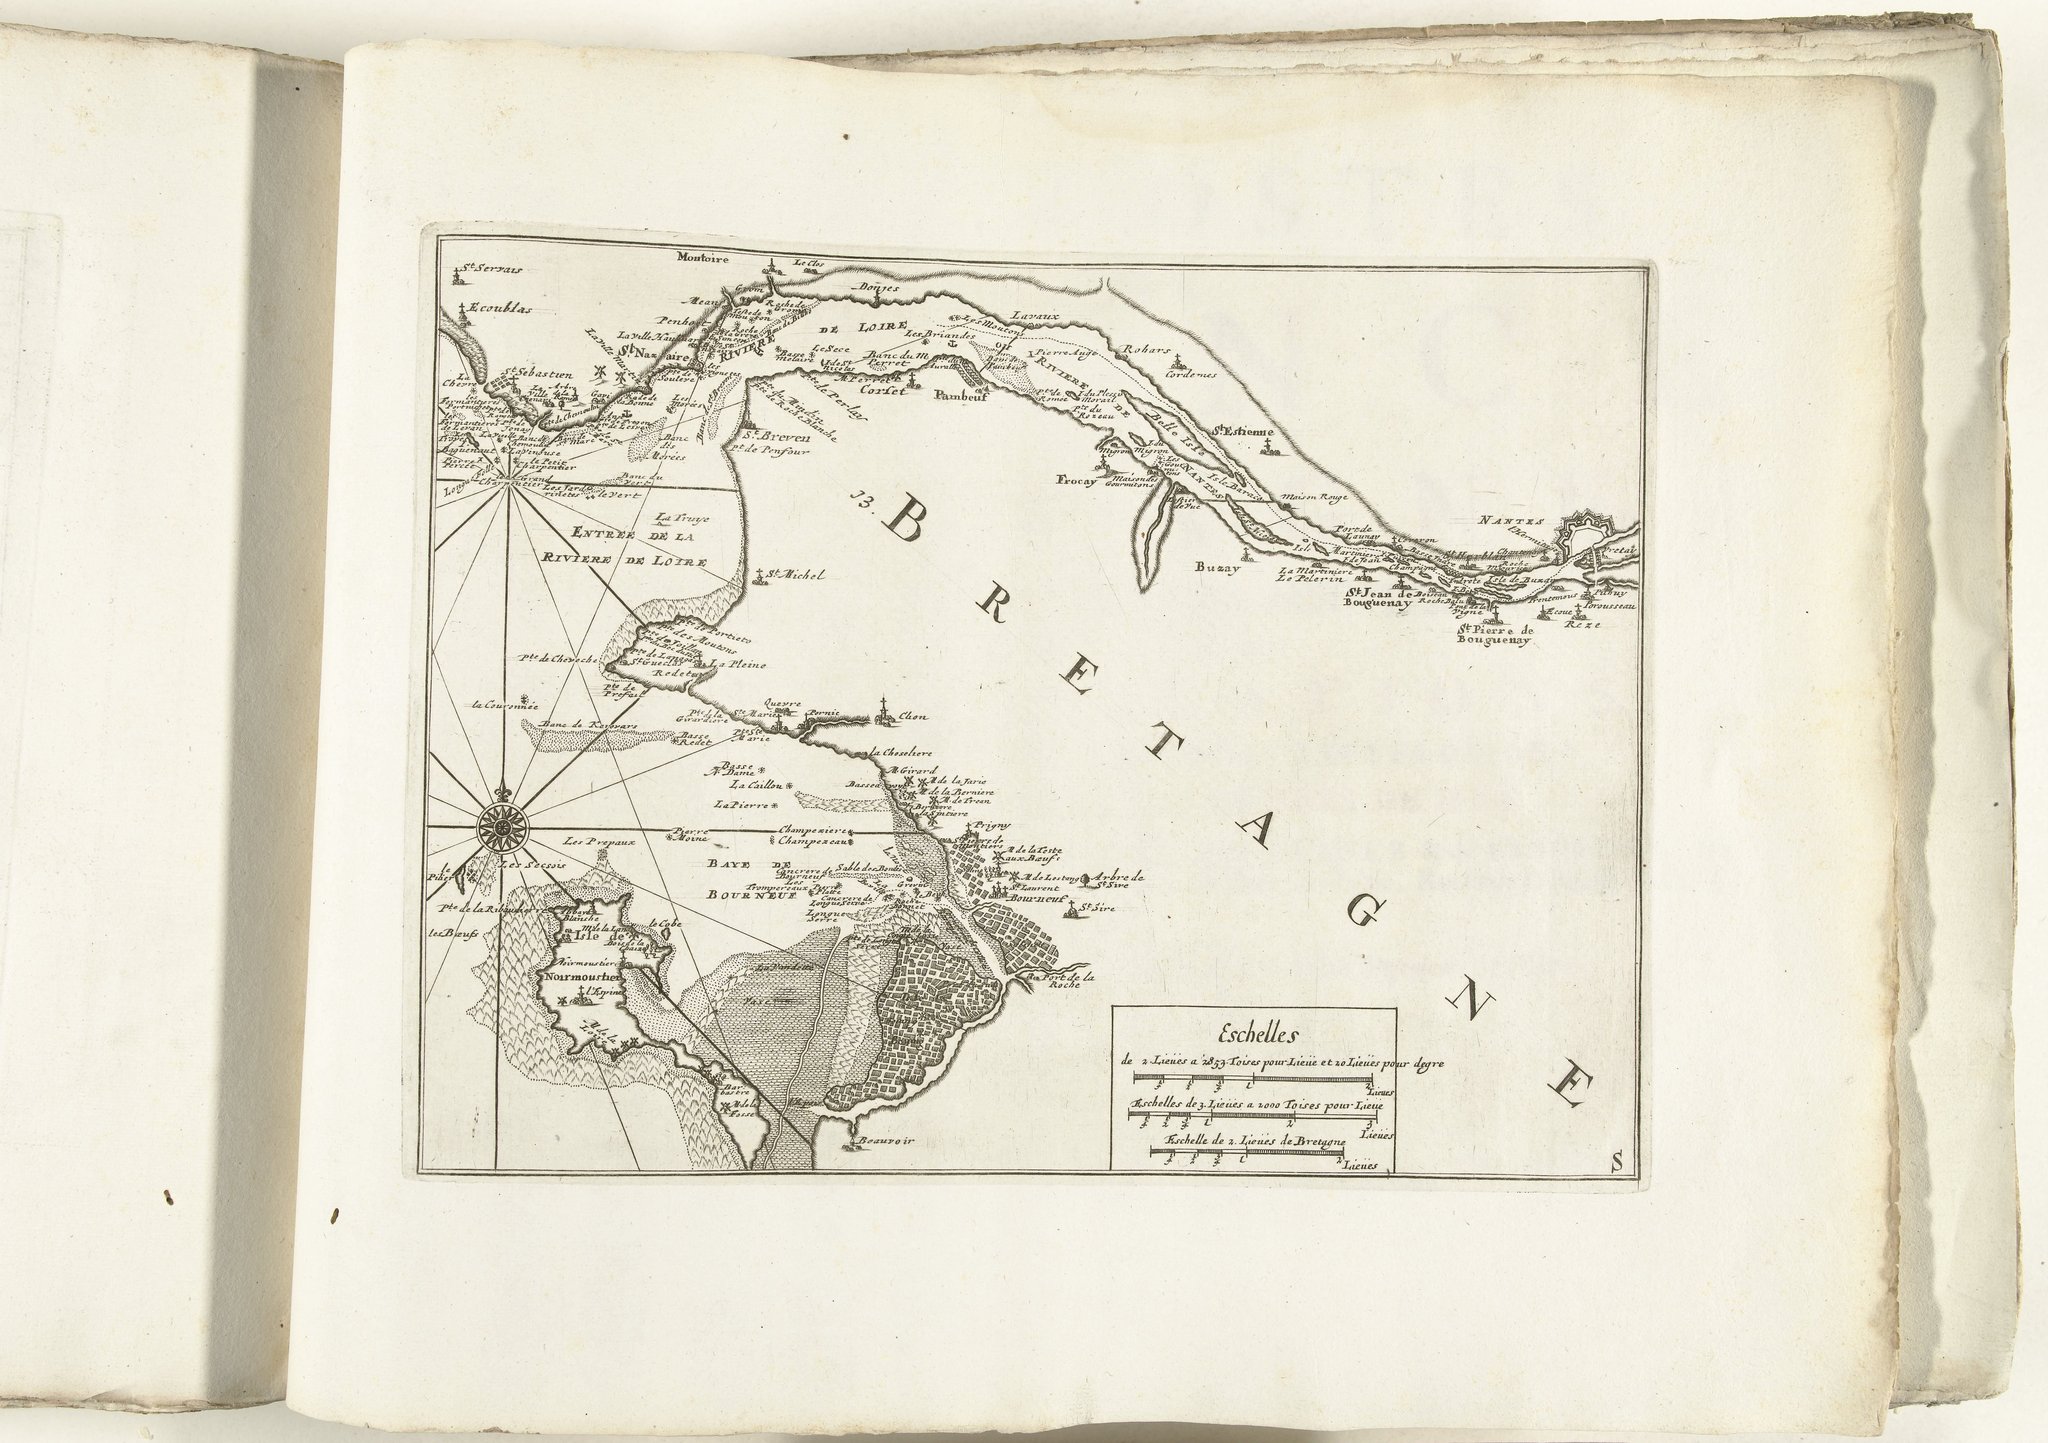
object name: map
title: Kaart van de zuidkust van Bretagne bij Nantes, ca. 1702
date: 1702-1703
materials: paper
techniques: engraving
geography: northern netherlands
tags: maps of separate countries or regions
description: Kaart van de zuidkust van Bretagne bij Nantes. Gemerkt rechtsonder: S. Onderdeel van het eerste van twee delen van het prentwerk: Les costes de France et d'Espagne (oftewel deel 13 van: Les Forces de l'Europe, Asie, Afrique et Amerique), uitgegeven ca. 1702. Het prentwerk bestaat in totaal uit 43 gemerkte platen van de kust van Frankrijk en Spanje, in het kader van de Spaanse Successieoorlog. Deze platen zijn gekopieerd naar anonieme Franse platen oorspronkelijk uitgegeven door Nicolas de Fer te Parijs. Titel en opschriften in de plaat in het Frans.